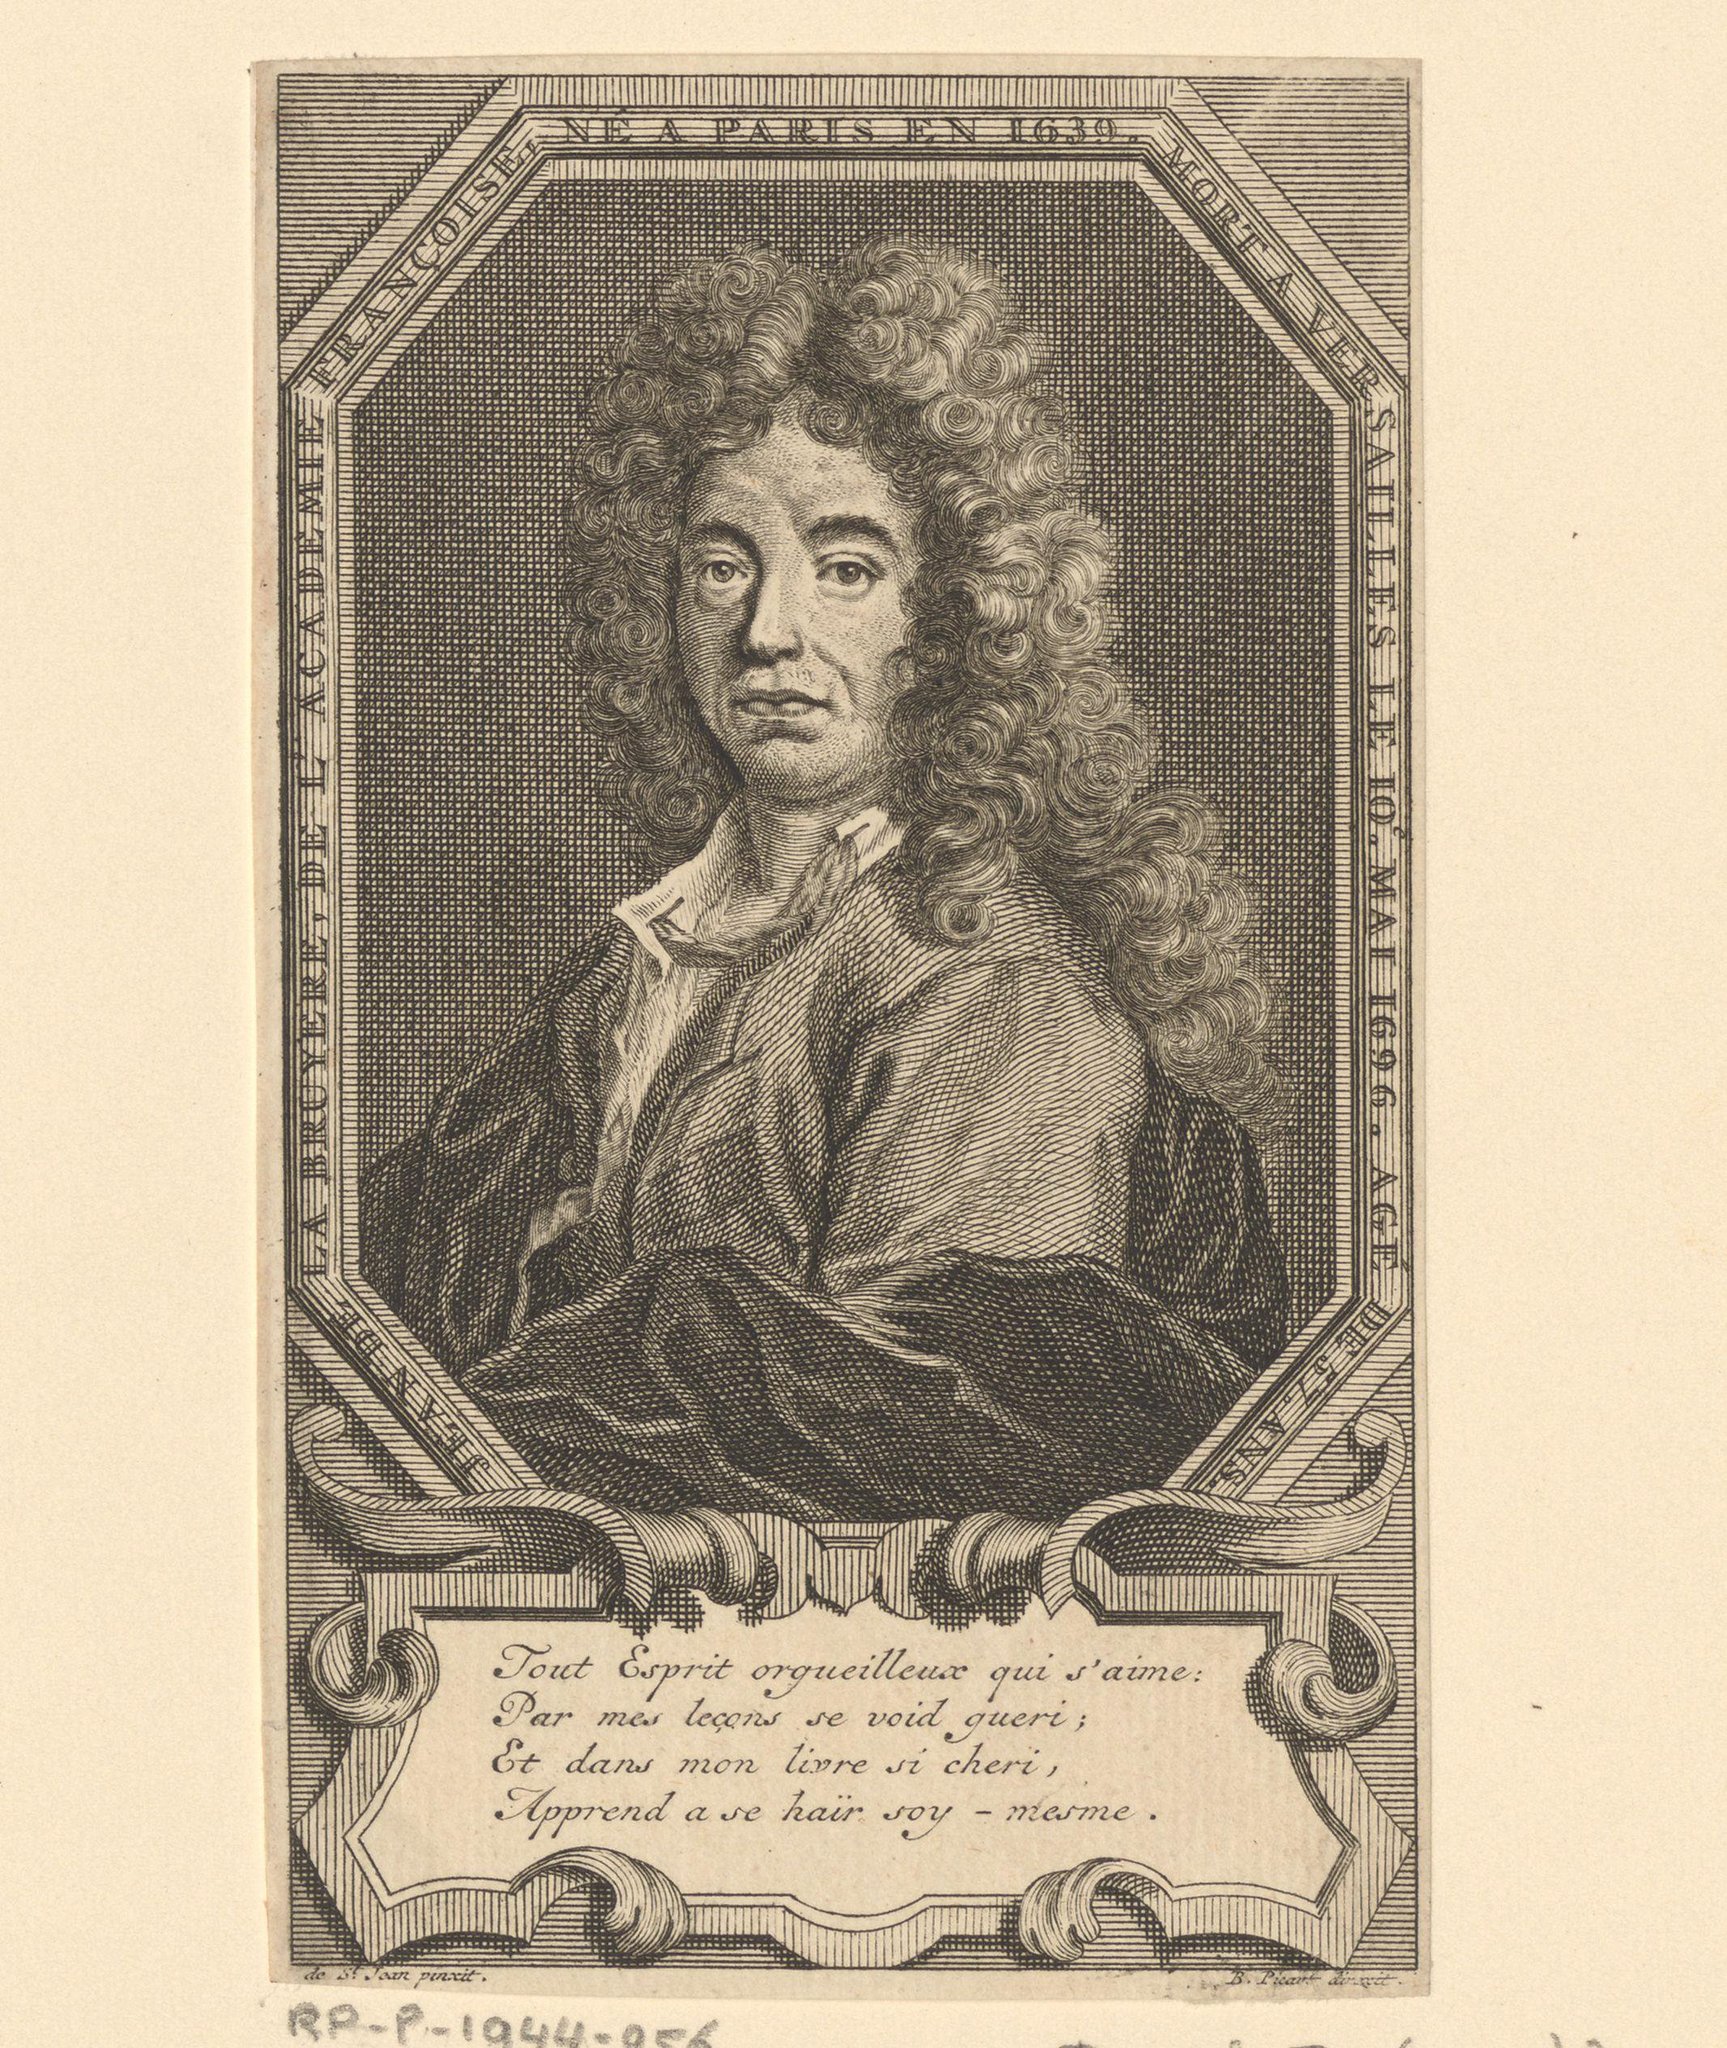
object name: print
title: Portret van Jean de la Bruyère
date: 1696-1733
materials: paper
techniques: engraving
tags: historical persons, portrait of a writer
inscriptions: collector's mark: Lugt 2228, collector's mark: Lugt 240